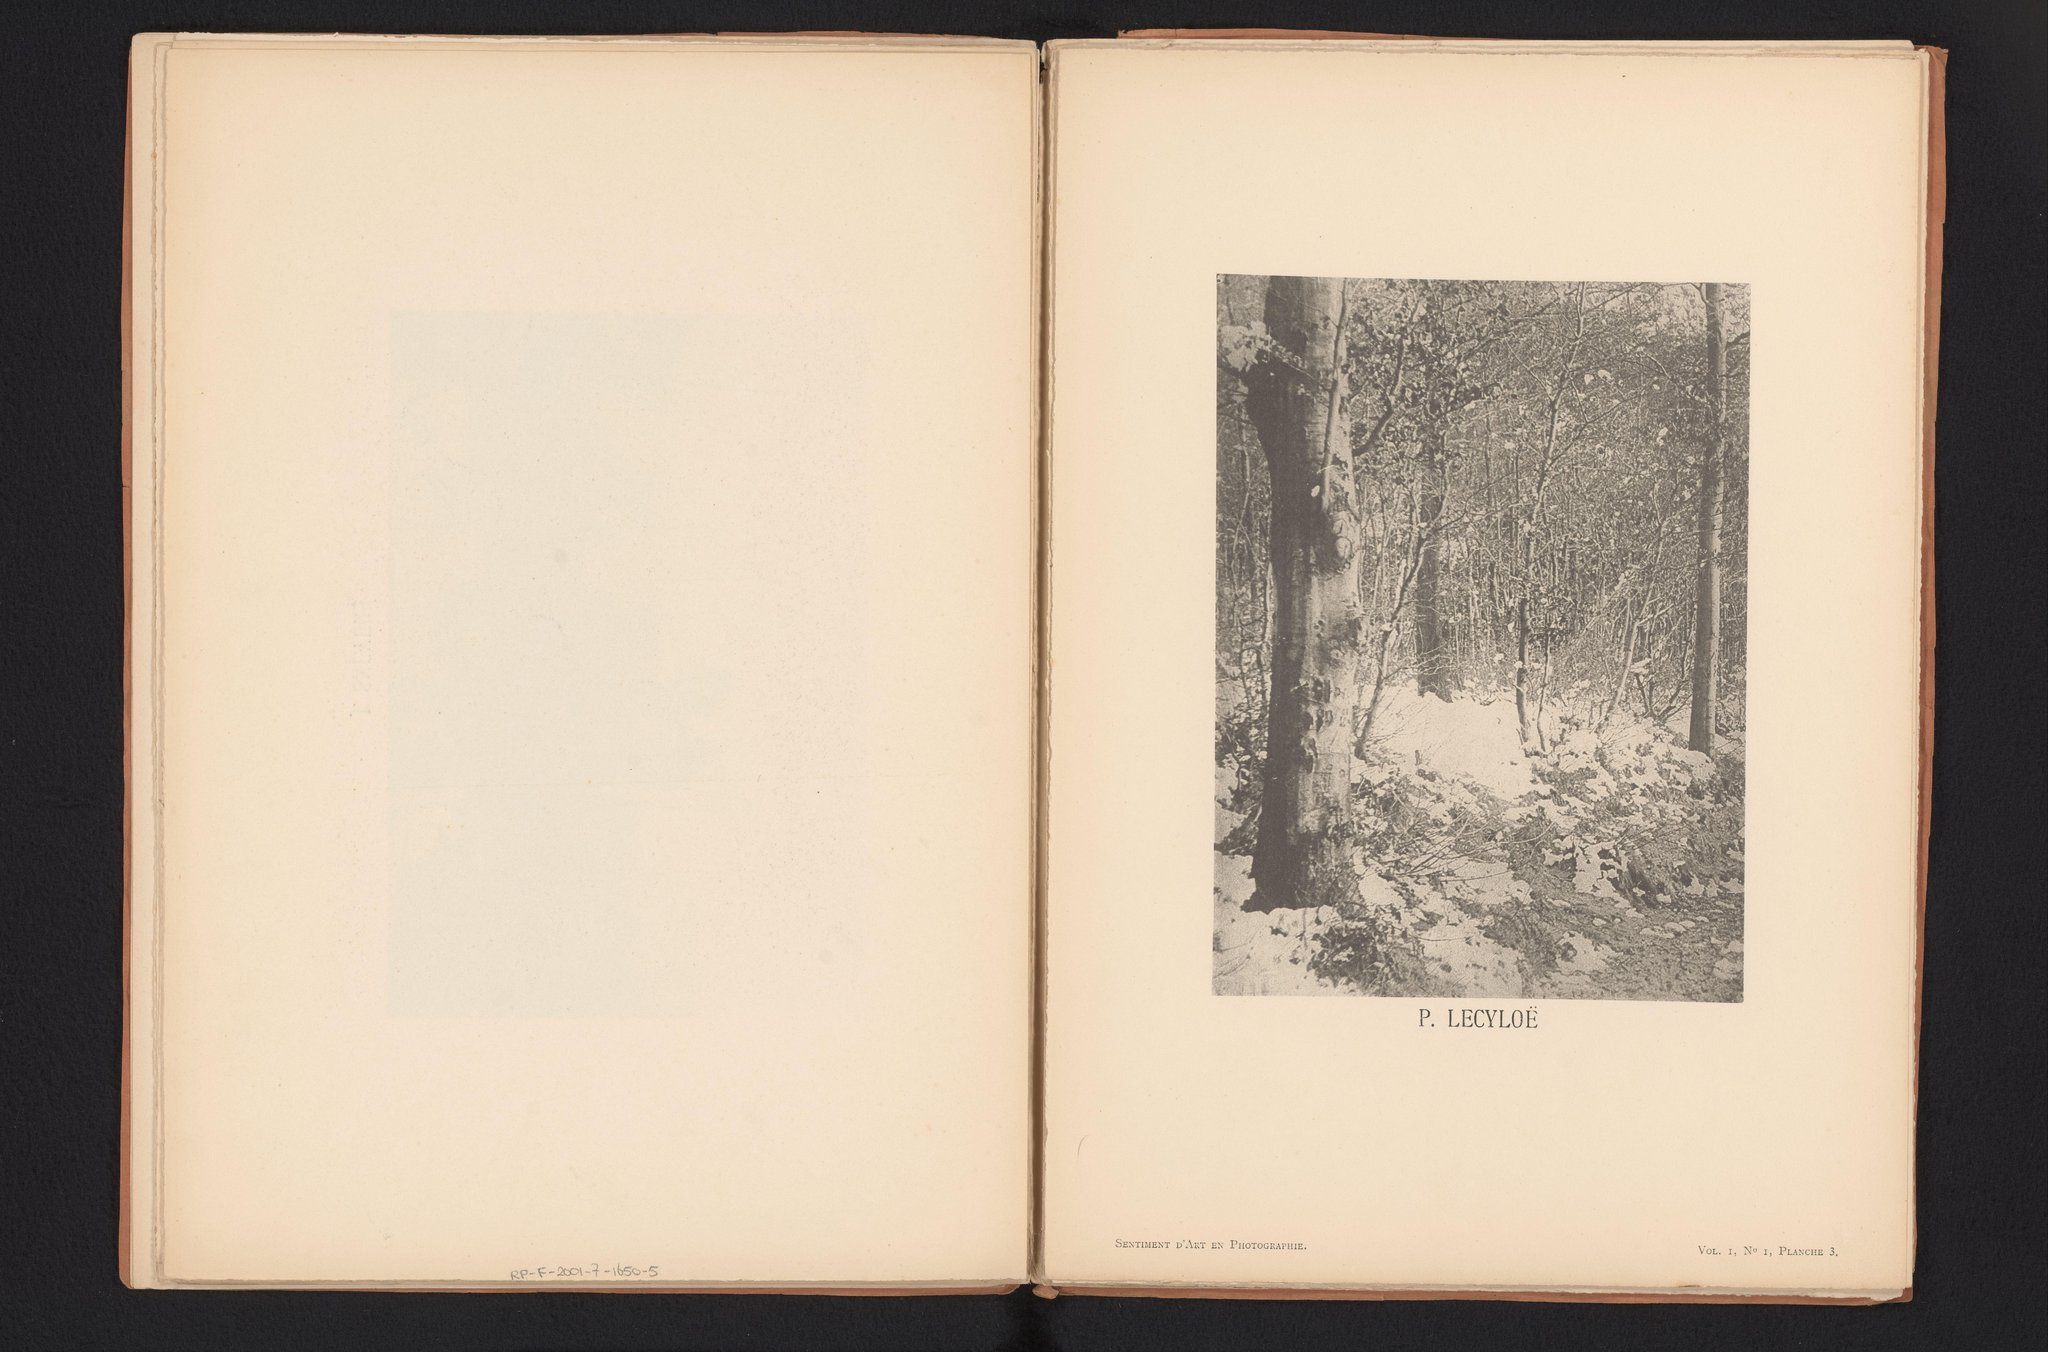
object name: photomechanical print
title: Bomen in de sneeuw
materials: paper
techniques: photograph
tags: trees, snow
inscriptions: number: ‘Vol. 1, No 1, Planche 3.’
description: Deze prent maakt deel uit van 8 omslagen met 22 tekstbladen en 89 prenten op losse bladen in en tussen de omslagen.